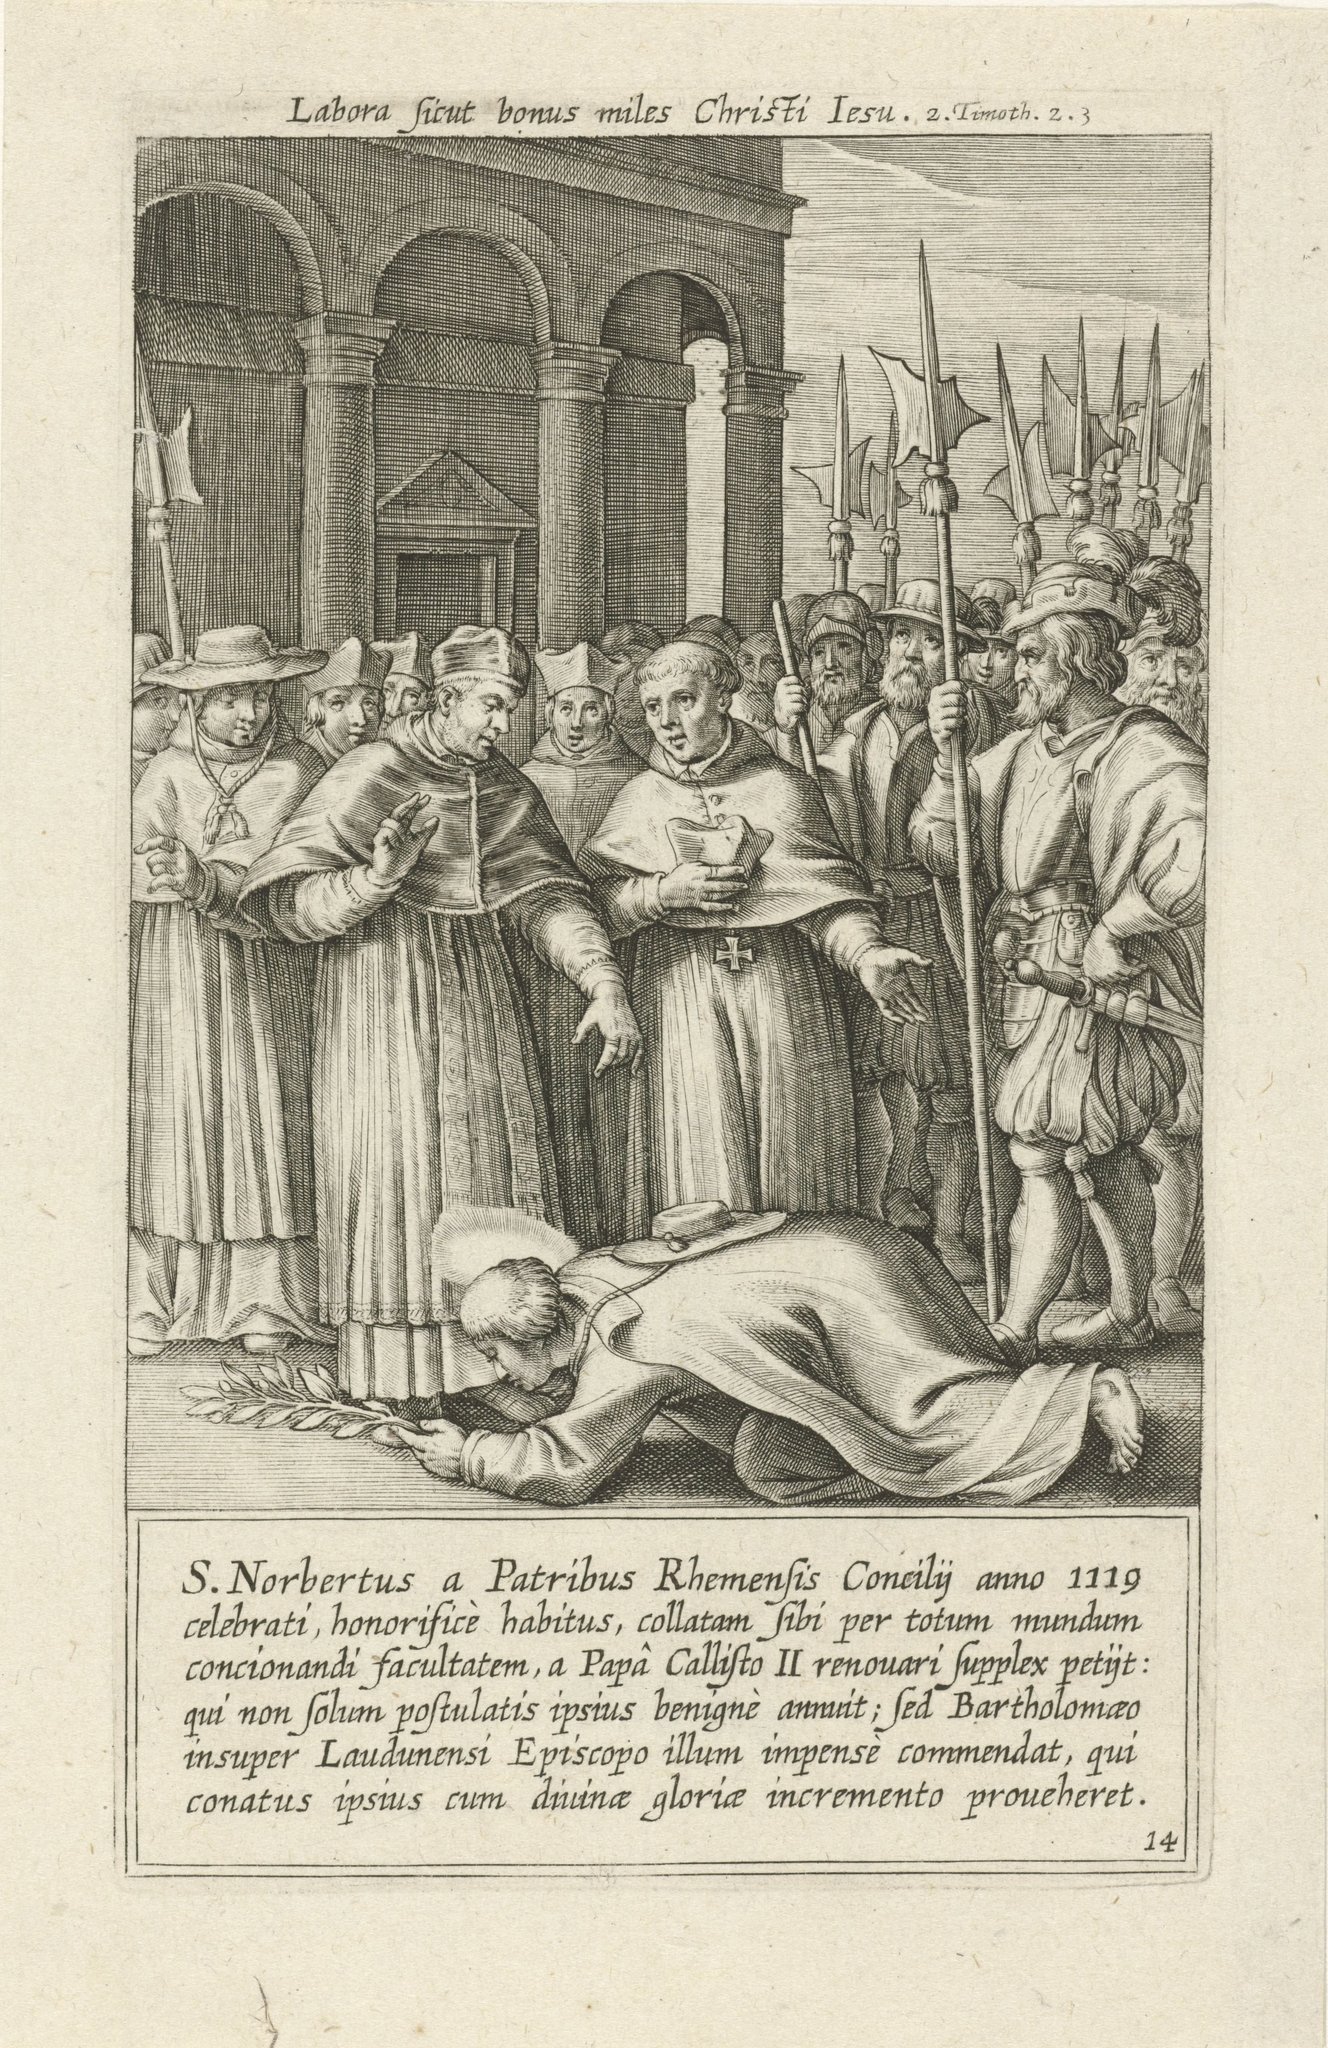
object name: print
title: Ontmoeting tussen de heilige Norbertus en paus Calixtus II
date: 1622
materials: paper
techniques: engraving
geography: antwerp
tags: non-miraculous activities and events ~ st. norbert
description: De heilige Norbertus knielt voor paus Calixtus II en kust zijn voeten. De prent heeft twee Latijnse opschriften: een boven en een onder de voorstelling.